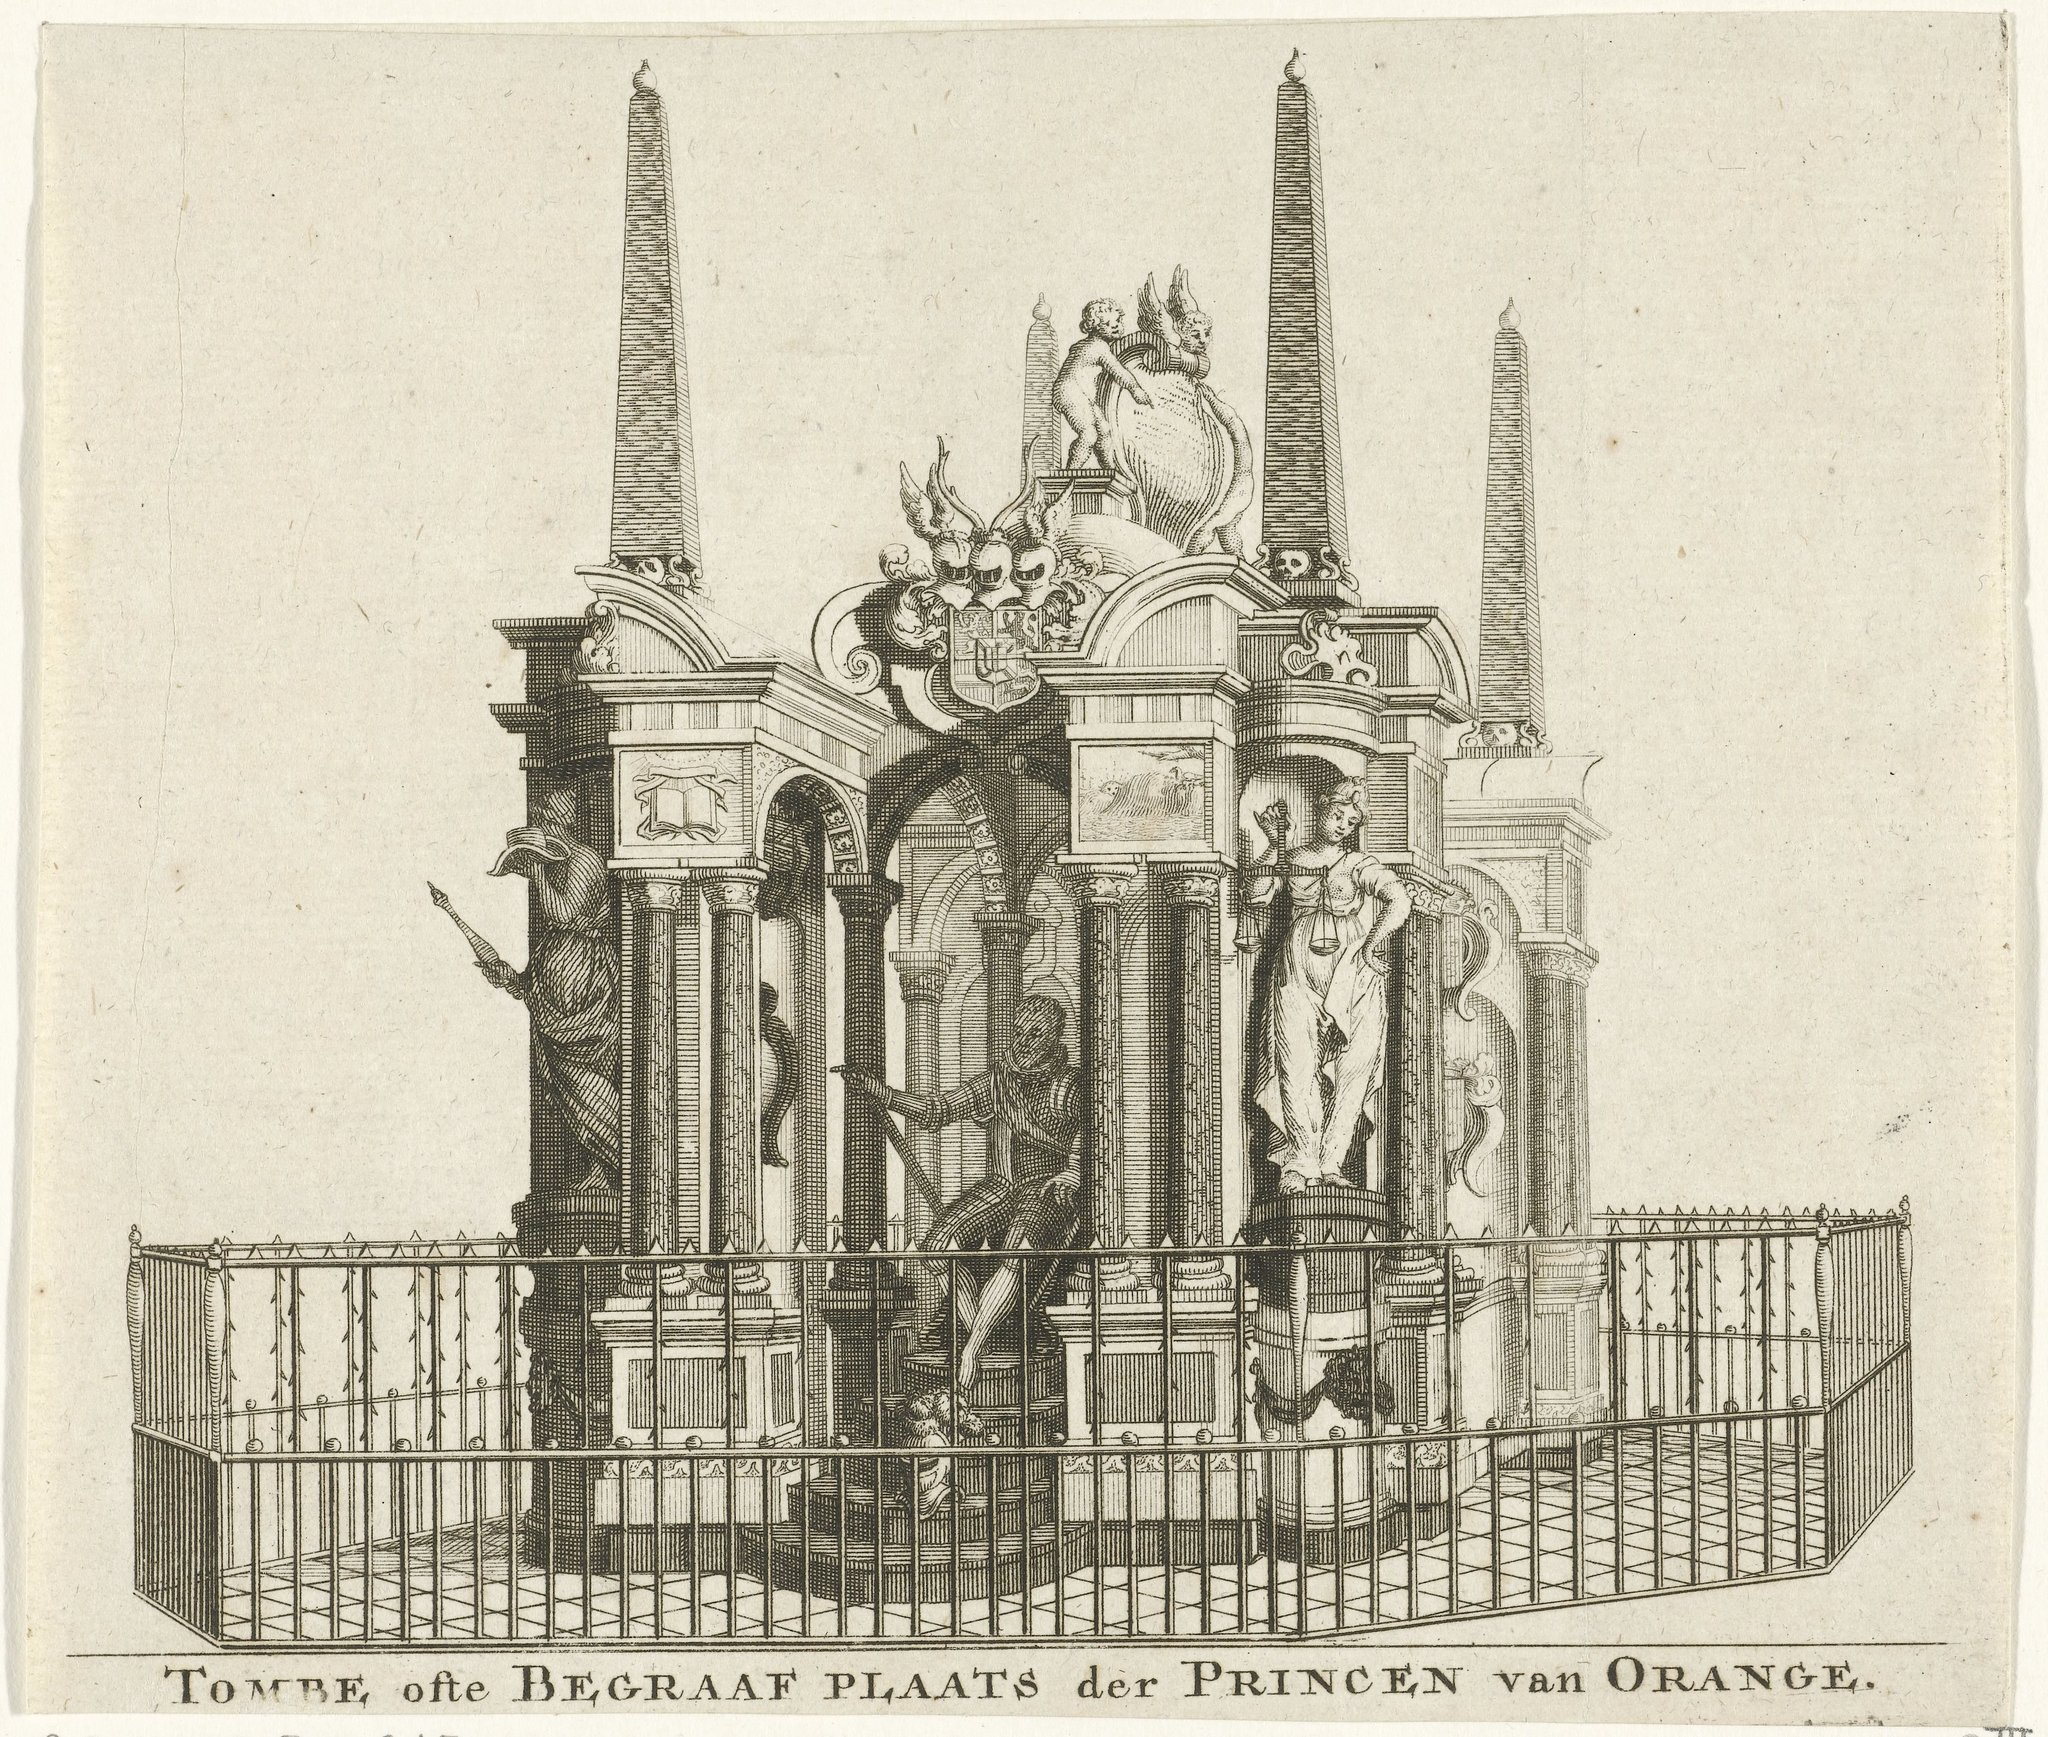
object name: print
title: De graftombe van Willem van Oranje, 1623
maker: Anonymous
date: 1700-1799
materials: paper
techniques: etching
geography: netherlands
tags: delft, william i (prince of orange), grave-building, monumental tomb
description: De graftombe of praalgraf van Willem van Oranje in de Nieuwe Kerk te Delft, voltooid in 1623.